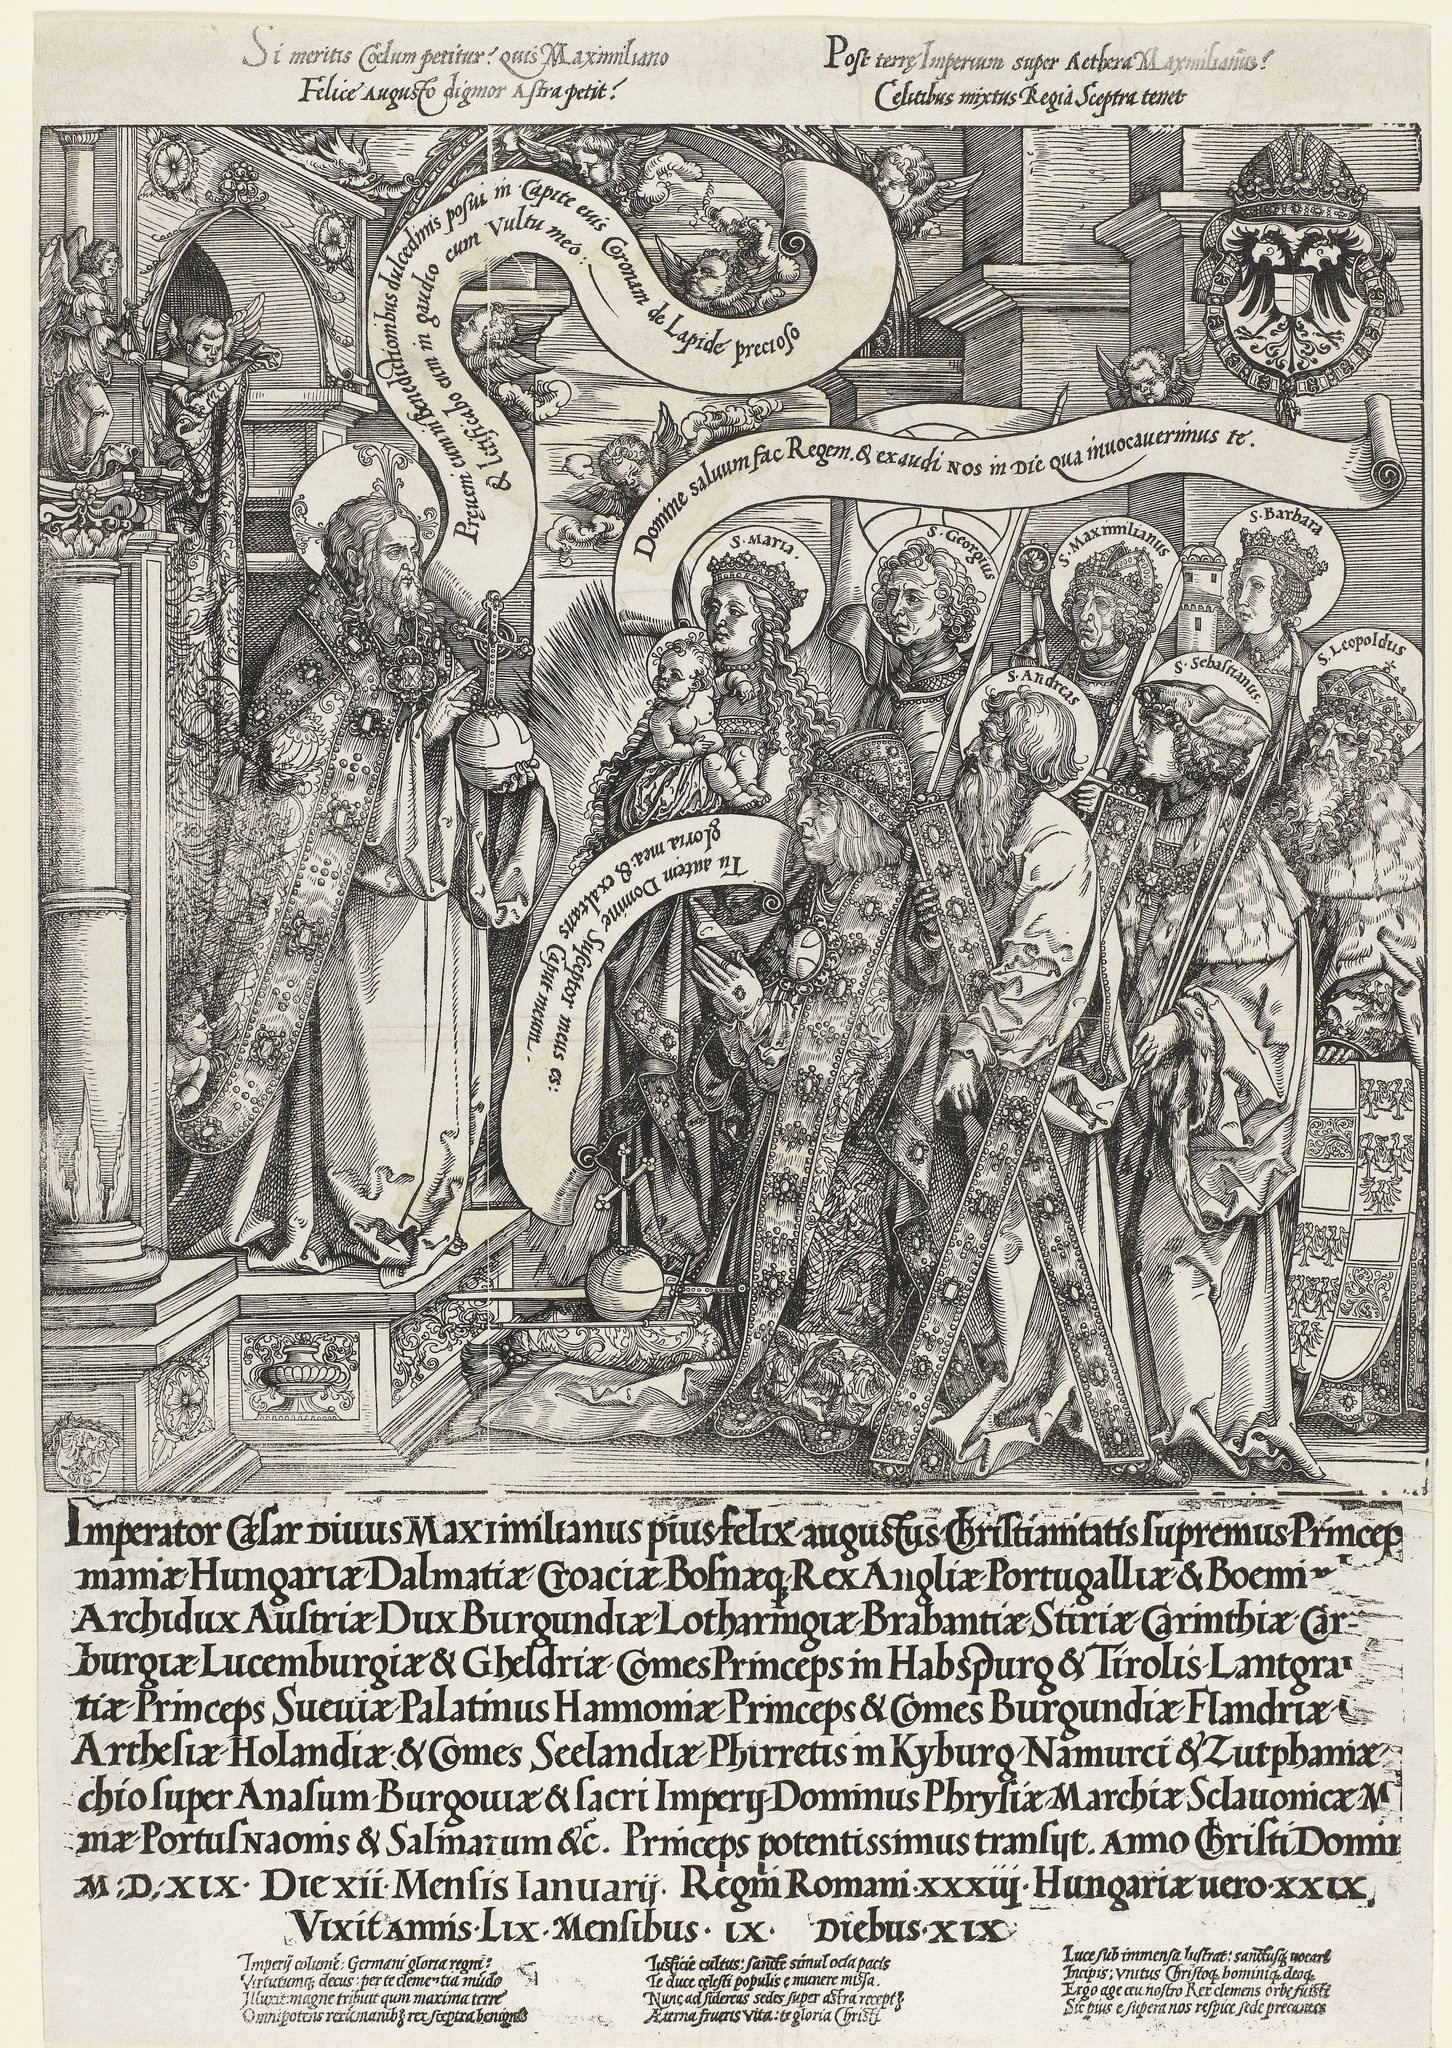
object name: print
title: Keizer Maximiliaan I knielt voor Christus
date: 1519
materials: paper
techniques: woodcut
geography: nuremberg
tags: maximilian i (holy roman emperor), the virgin martyr barbara; possible attributes: book, cannon(ball), crown, cross, chalice with wafer, dioscuros (her father), peacock feather, sword, torches, mason's tools, tower, the apostle andrew; possible attributes: book, x-shaped cross, fish, fishing-net, rope, scroll, the martyr sebastian; possible attributes: arrow(s), bow, tree-trunk, male saints (with name), madonna (or mary without christ-child) as patroness or protectress, e.g. of a confraternity or lay order, the warrior martyr george (georgius); possible attributes: banner (red cross on white field), (red) cross, dragon, (white) horse, broken lance, shield (with cross), sword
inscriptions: collector's mark: Lugt 240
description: Keizer Maximiliaan I knielt voor Christus, omringd door de Heilige Joris, Maximiliaan, Barbara, Leopold, Sebastiaan, Andreas en Maria met het Christuskind. Binnen de voorstelling teksten op drie banderollen: één bij de mond van Maximiliaan, één bij de mond van Maria en één bij de mond van Christus. Boven en onder de voorsteling teksten in het Latijn, deels in versvorm.